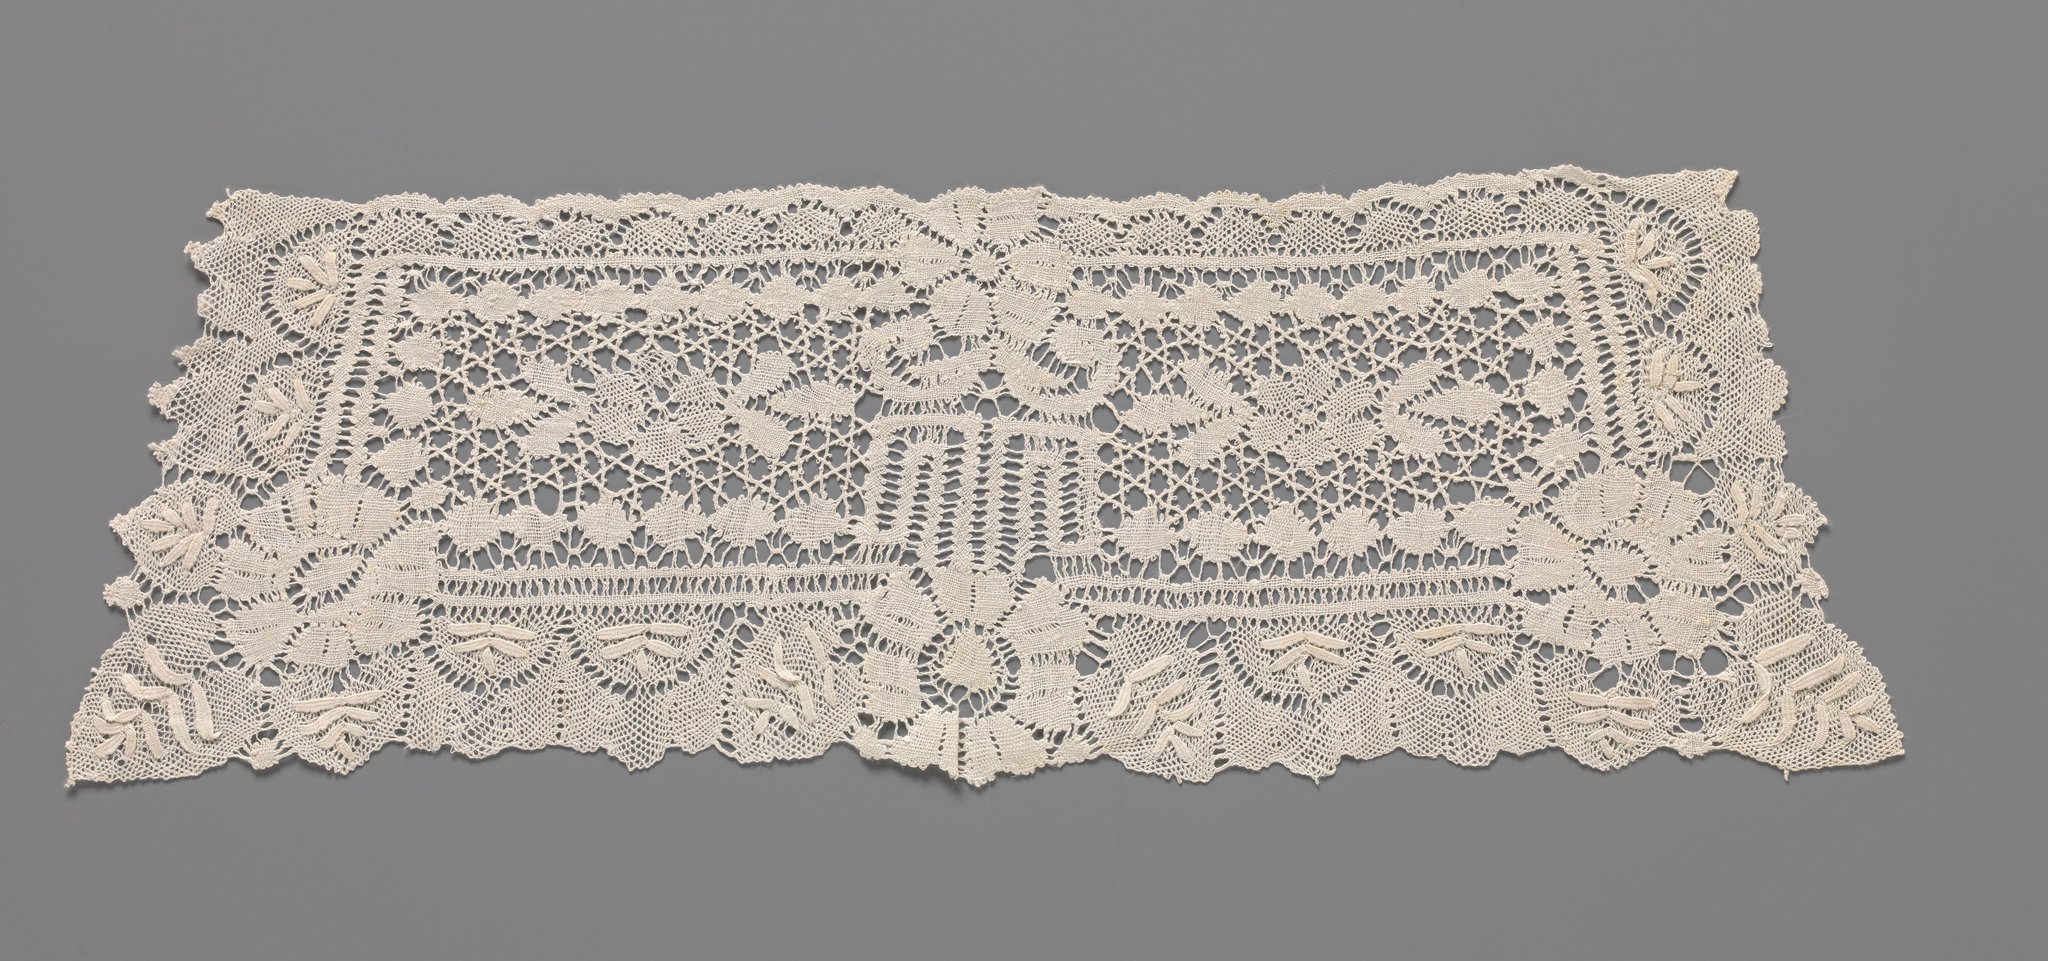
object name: cuff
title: Manchet van kloskant met symmetrisch patroon met drie grote en drie kleinere rozetbloemen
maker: Anonymous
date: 1910-1930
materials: cotton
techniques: lace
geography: le puy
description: Manchet van naturelkleurig kloskant: Cluny-kant. Trapeziumvormig model. Symmetrisch patroon met grote rozetbloemen onderaan het trapeziumvormig veld, één op elke hoekpunt en één in het midden onderaan. In het met een stervormige vlechtengrond met picots gevulde veld staan twee kleinere rozetbloemen, elk tussen drie bladeren. In het centrum van het veld staat een rechthoekig motief, mogelijk een bloempot, bekroond door voluten en een andere rozetbloem. Rondom het veld een schulpenrand van waaiervormige schulpen en spitsovale bladeren, beide versierd met 'reliëf-nerven' gemaakt in vormslag. De schulpen zijn geklost in netslag, de rozetbloemen en andere motieven in linnenslag.